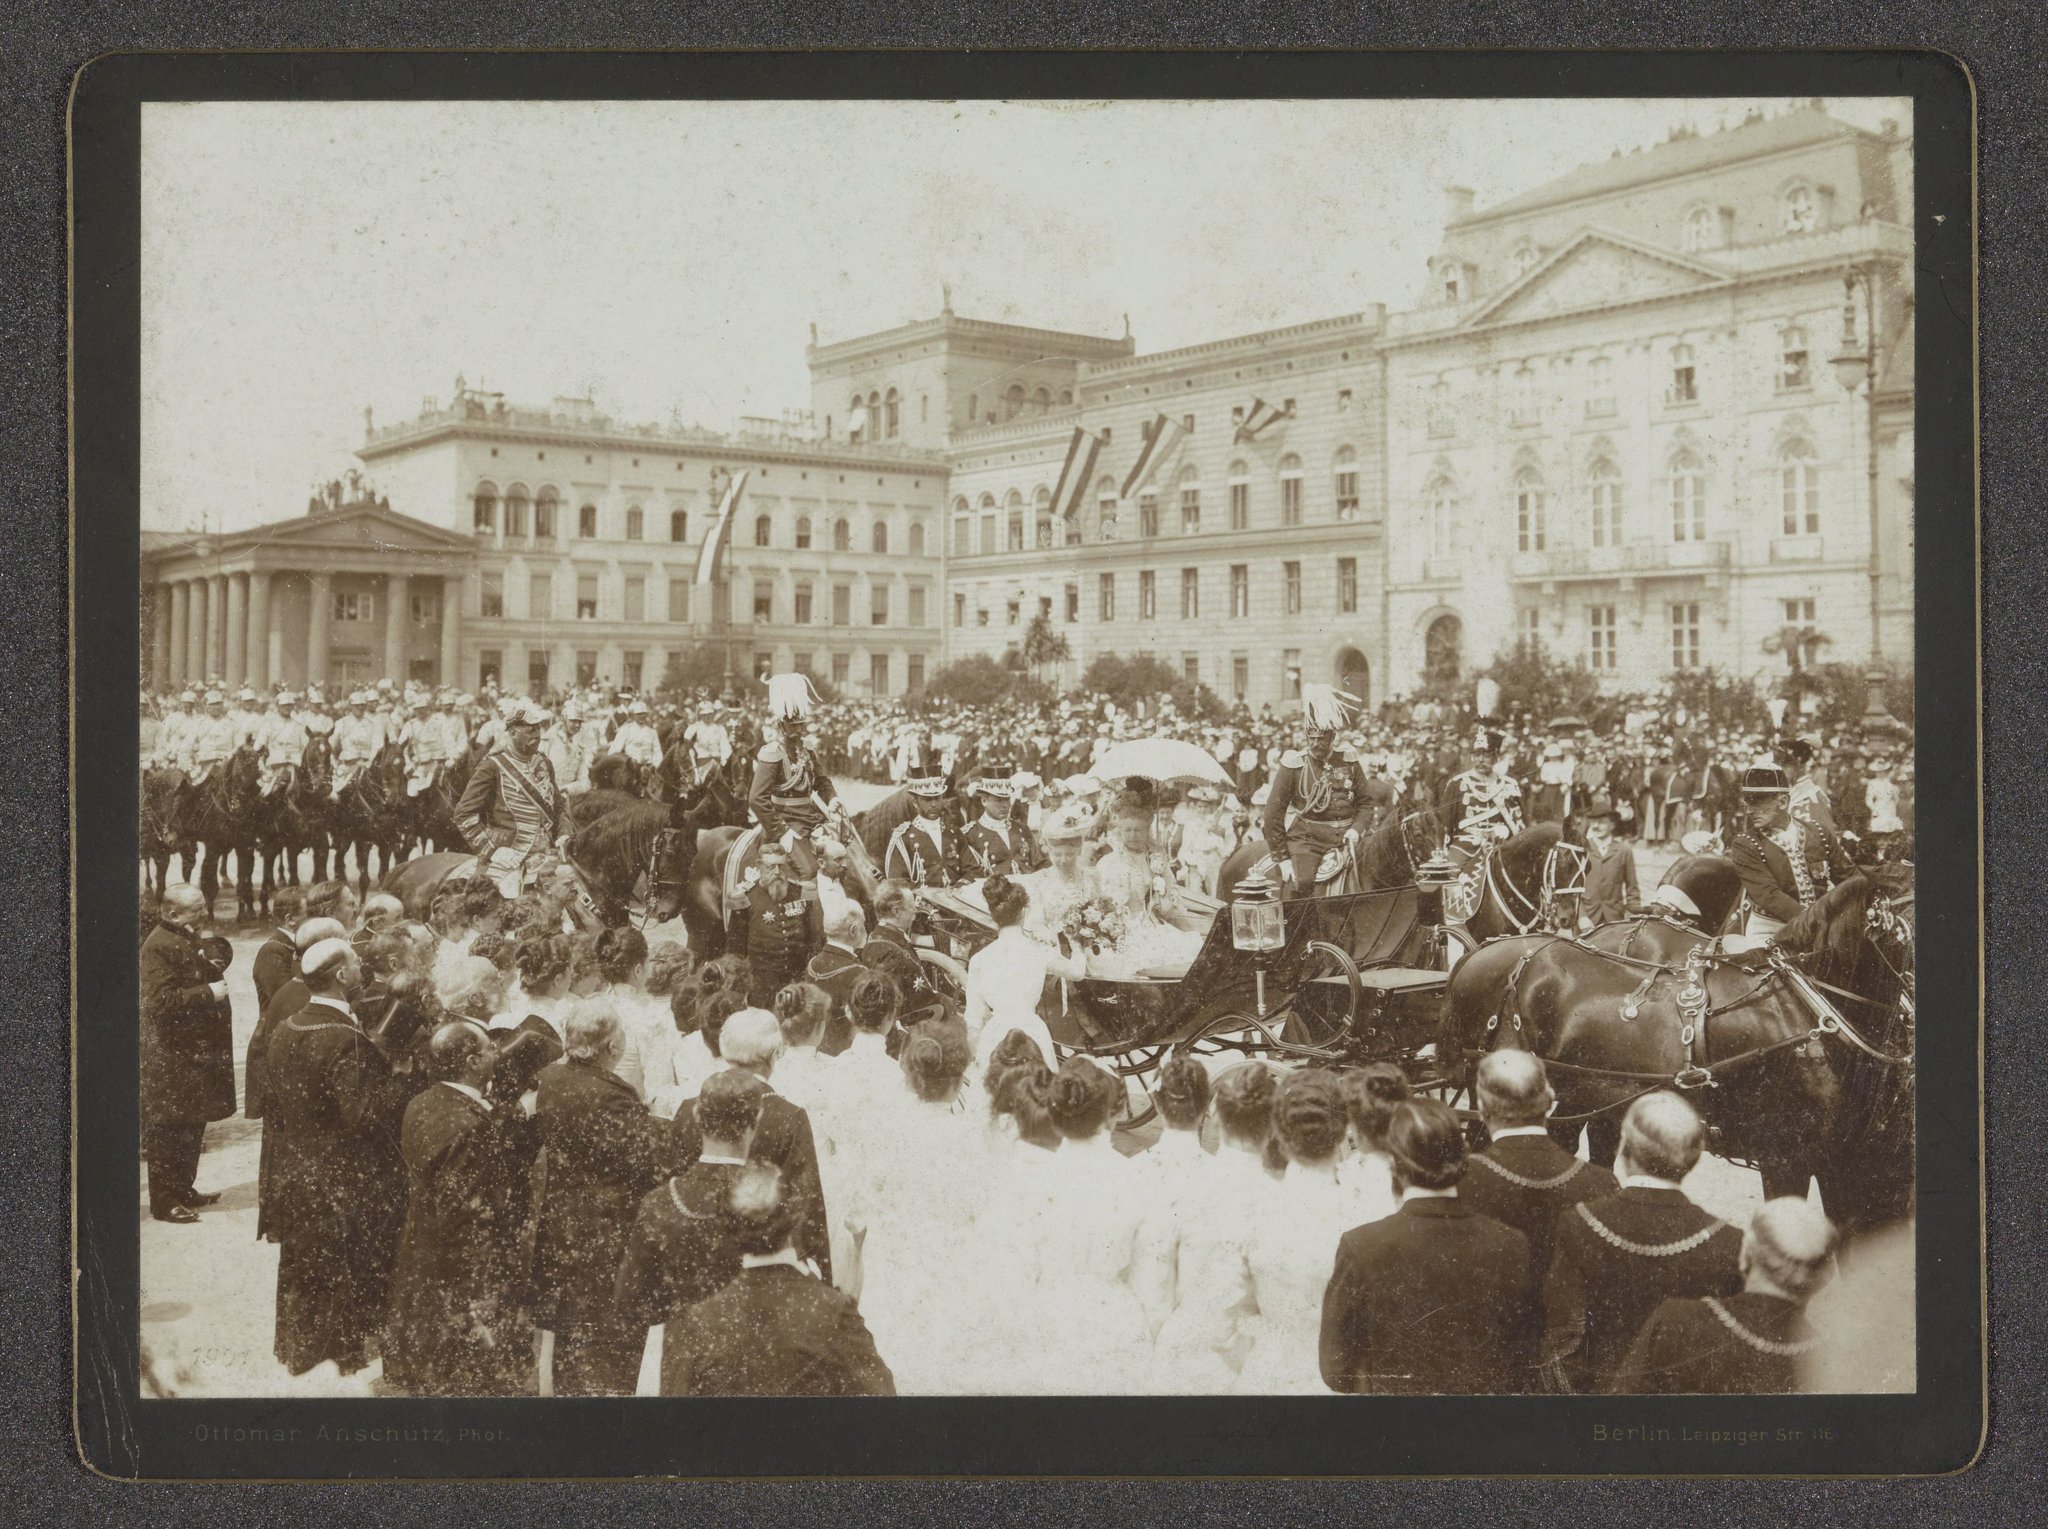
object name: photograph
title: bezoek Potsdam oktober 1899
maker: ottomar anschütz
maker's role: fotograaf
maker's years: 1846-1907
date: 1899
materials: photographic support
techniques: albumen print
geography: berlin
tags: print maker, wilhelmina of the netherlands, emma (queen consort of the netherlands), berlin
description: De plaatsaanduiding Potsdam in de titel op object is foutief.